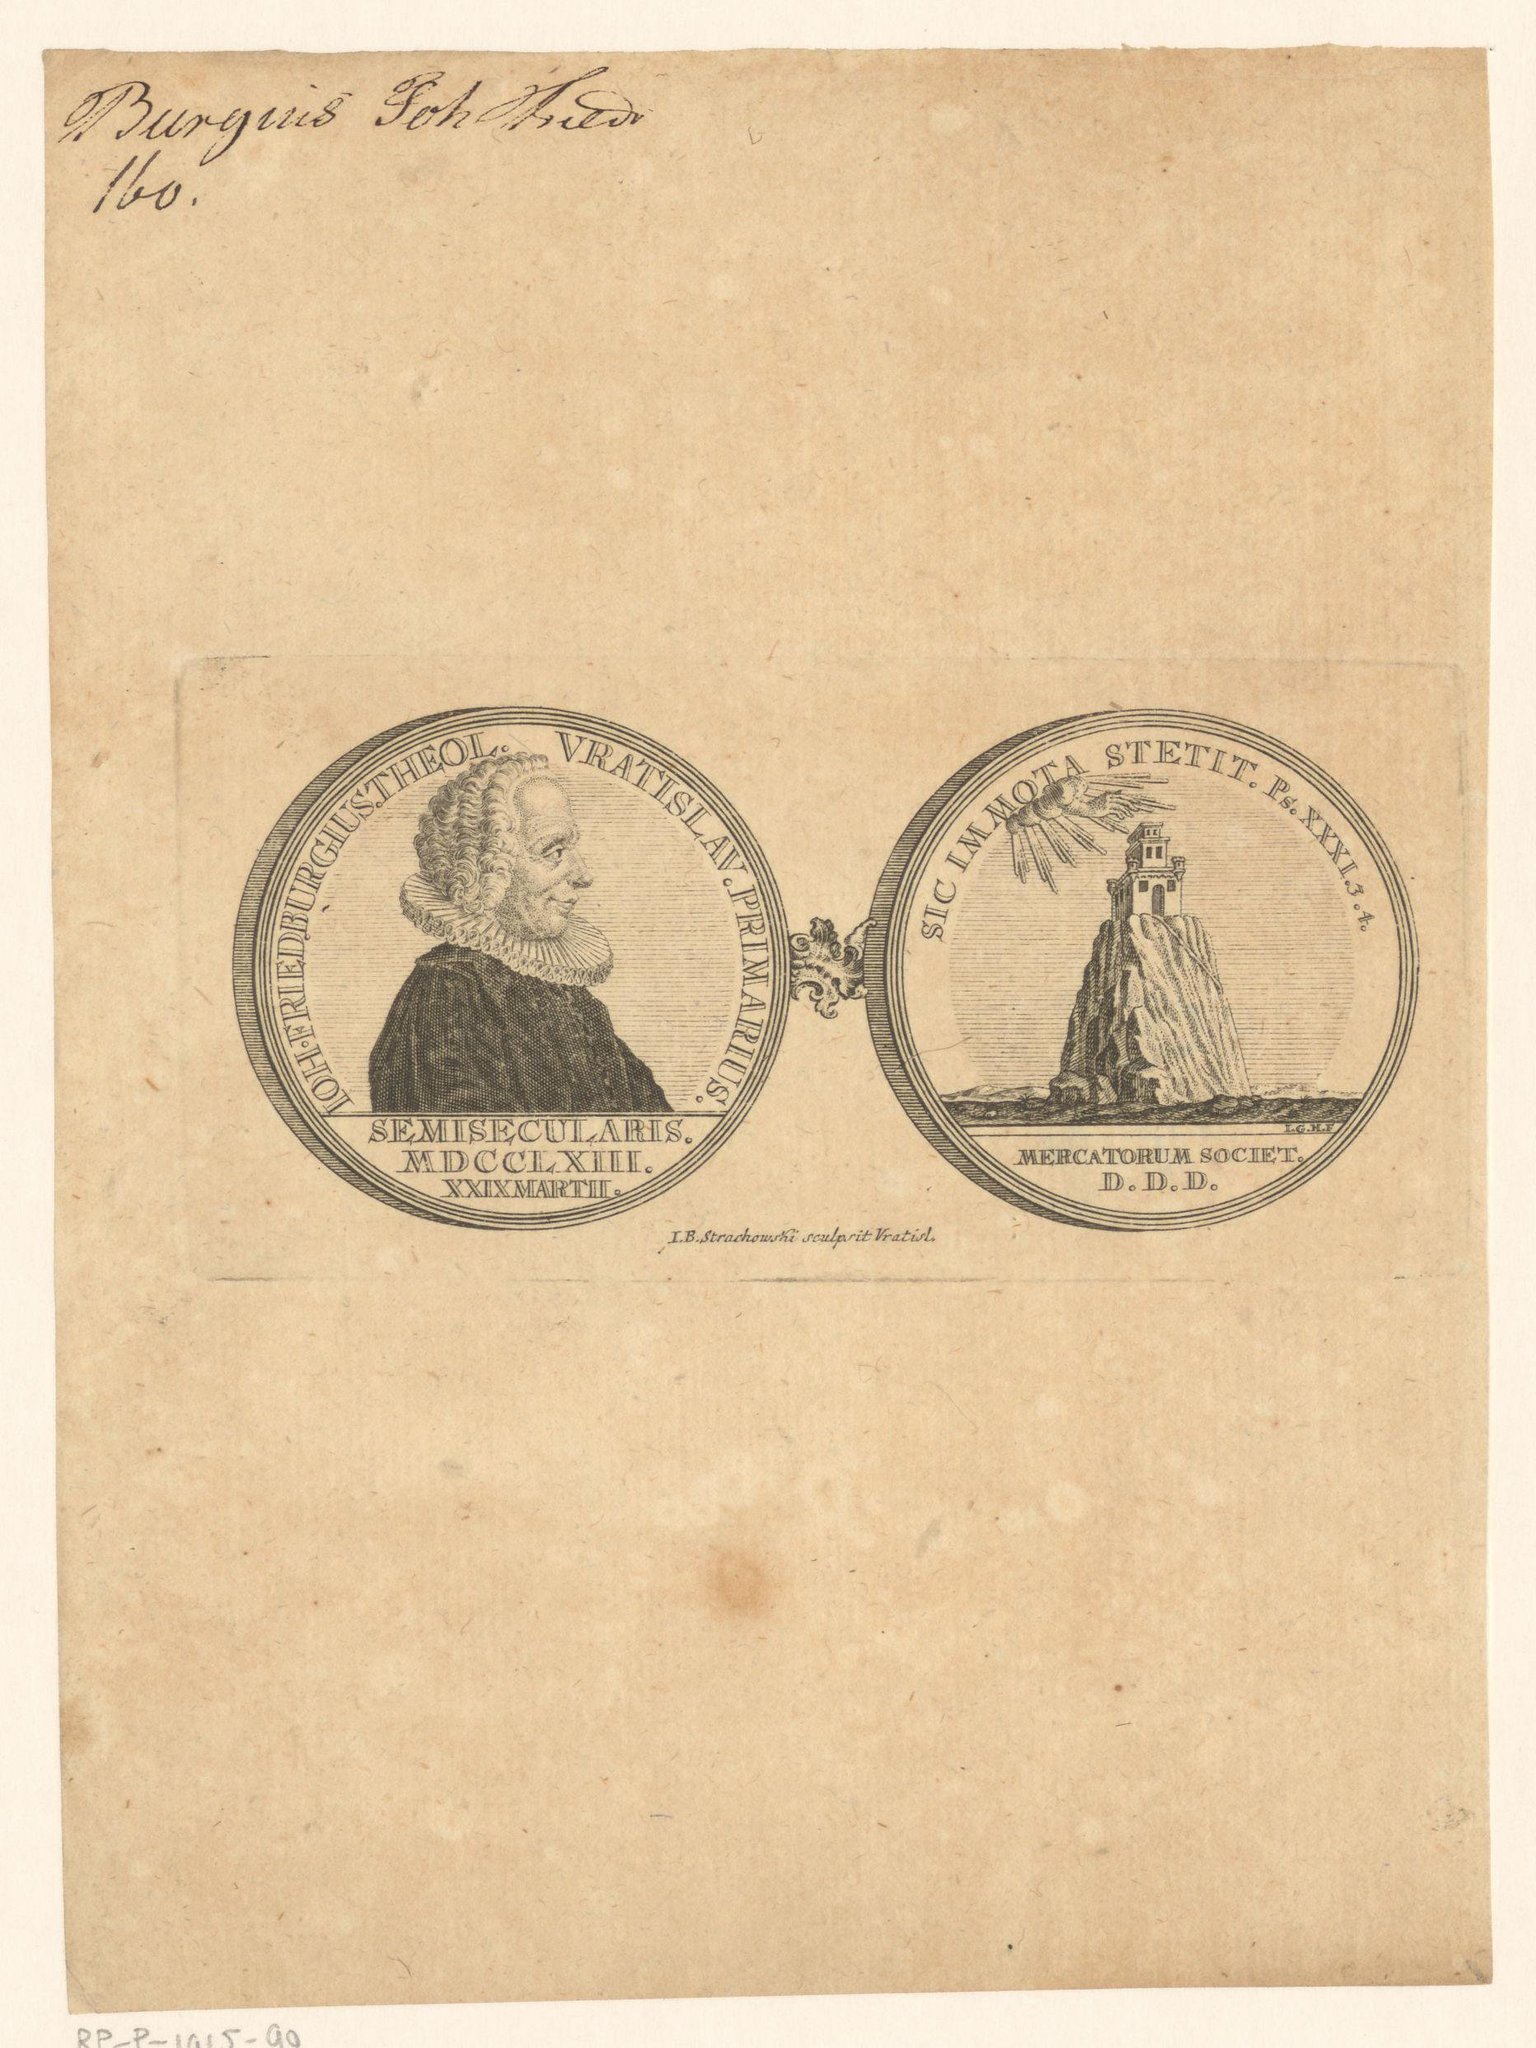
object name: print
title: Medaille met het portret van Johann Friedburg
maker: johann bartholomäus strahowsky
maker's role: print maker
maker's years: -1790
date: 1763-1790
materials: paper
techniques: engraving, etching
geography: breslau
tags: historical persons, medal (considered as a piece of sculpture, regardless of its specific function)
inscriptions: collector's mark: Lugt 2228